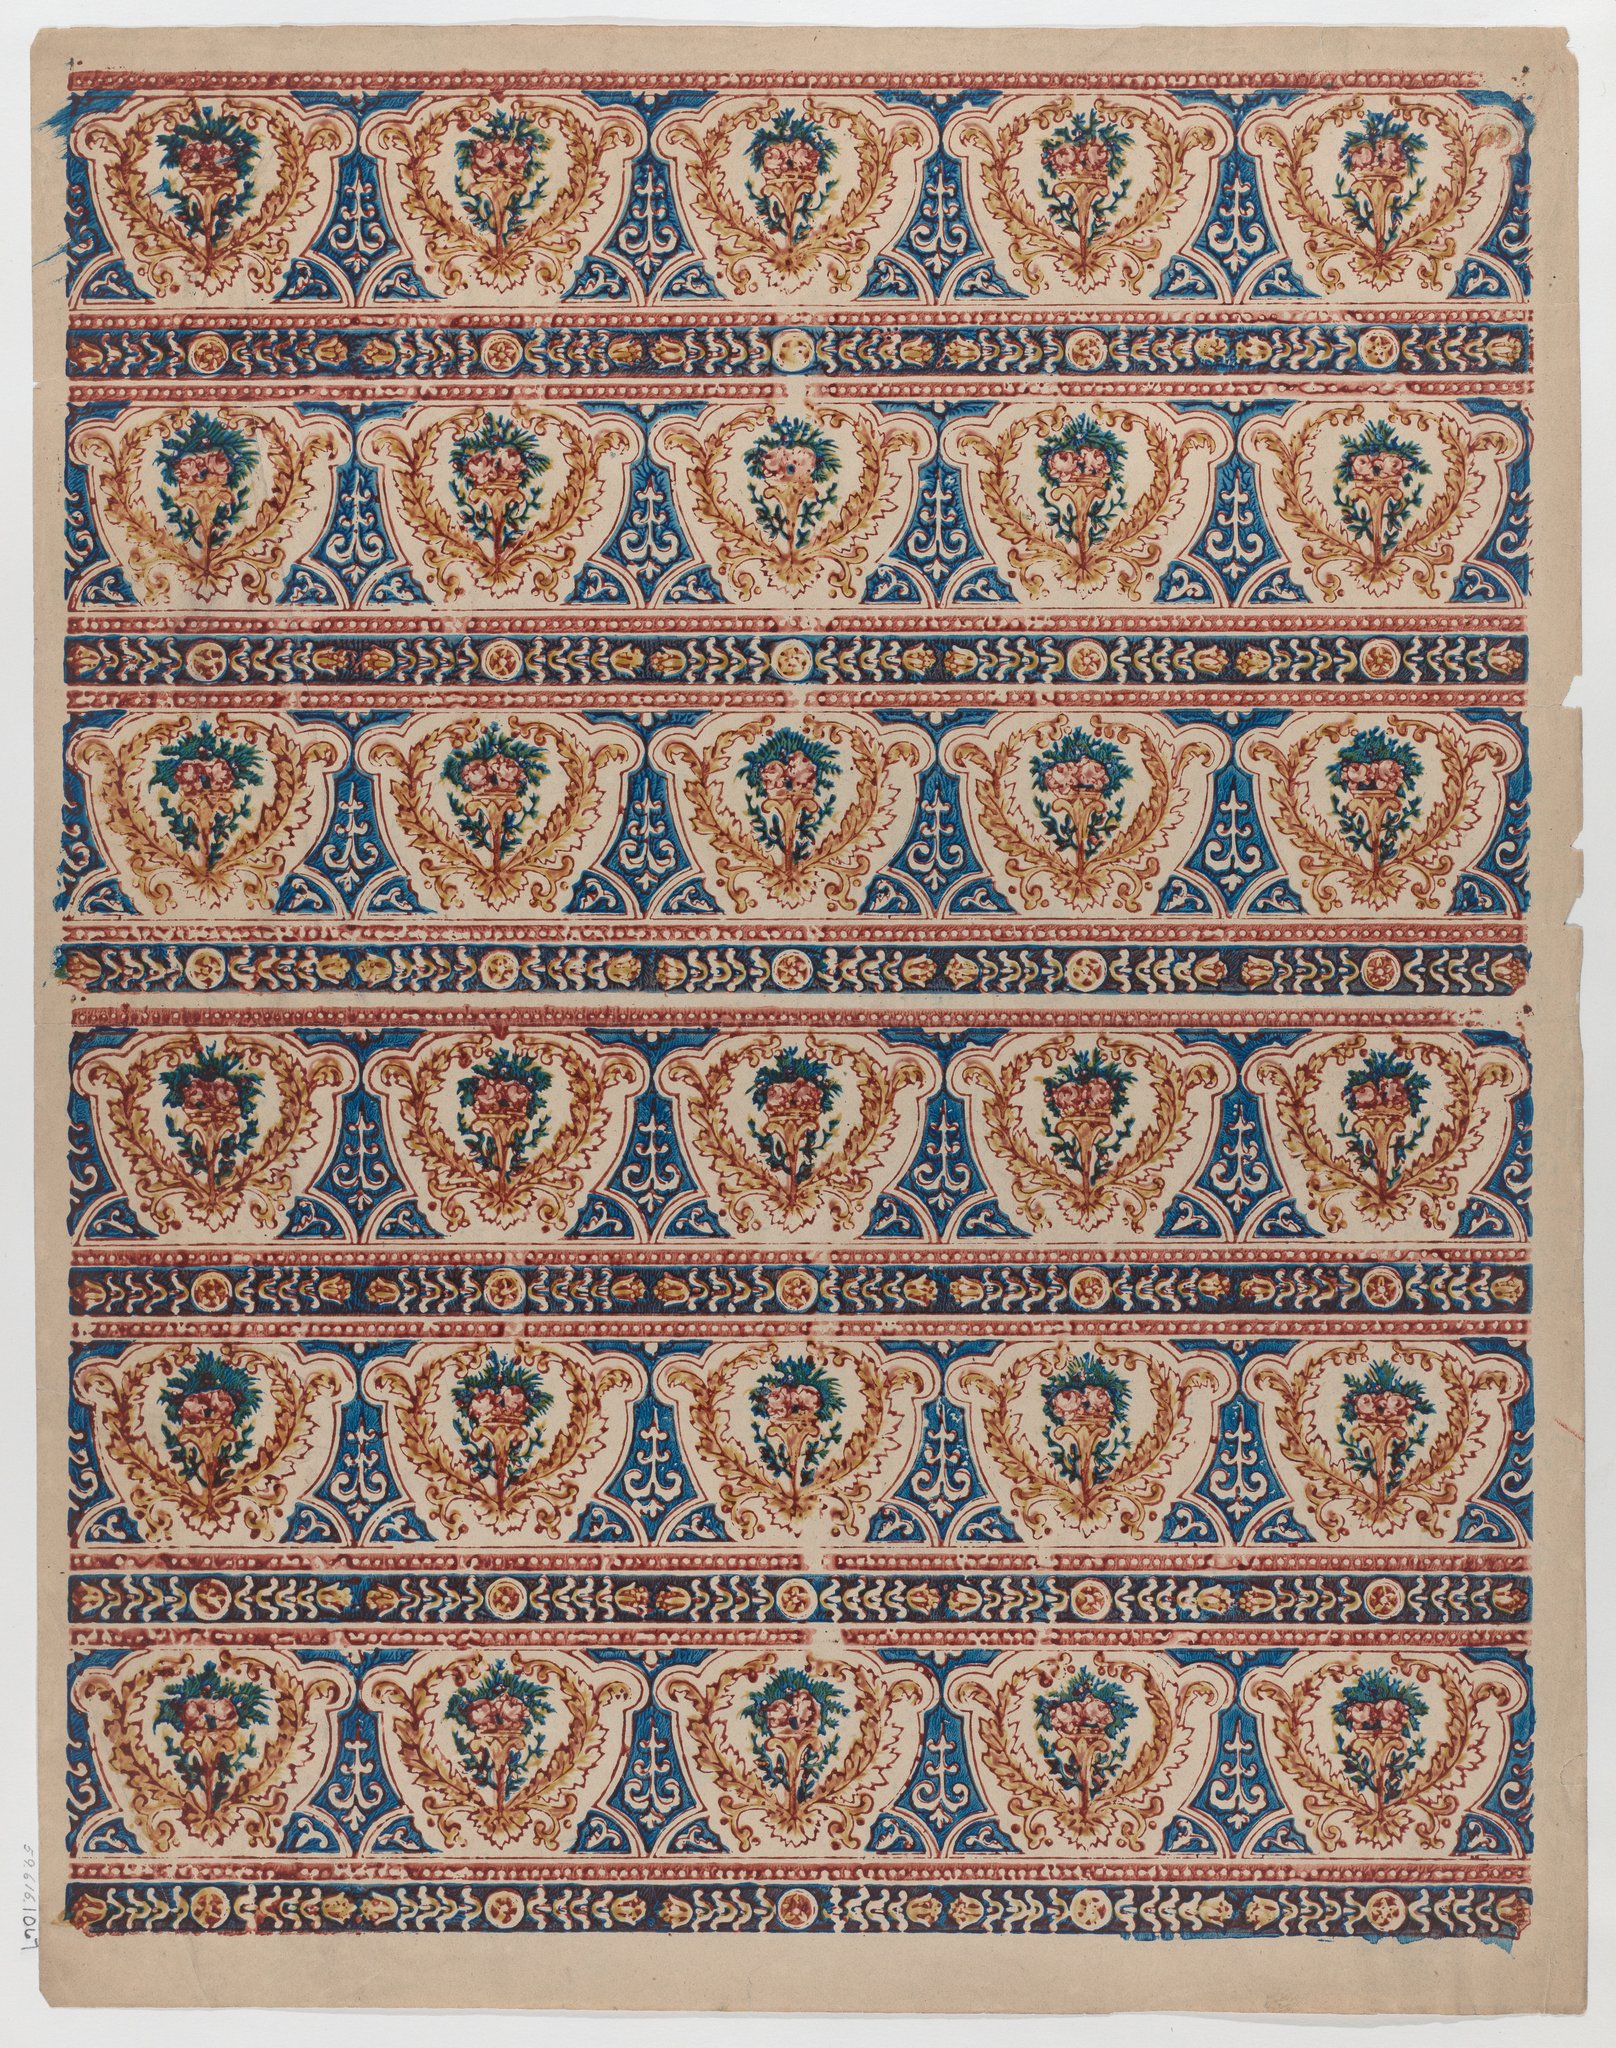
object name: print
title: Sheet with two borders with three bands each containing five wreaths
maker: Anonymous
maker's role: artist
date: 1767-1866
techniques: relief print